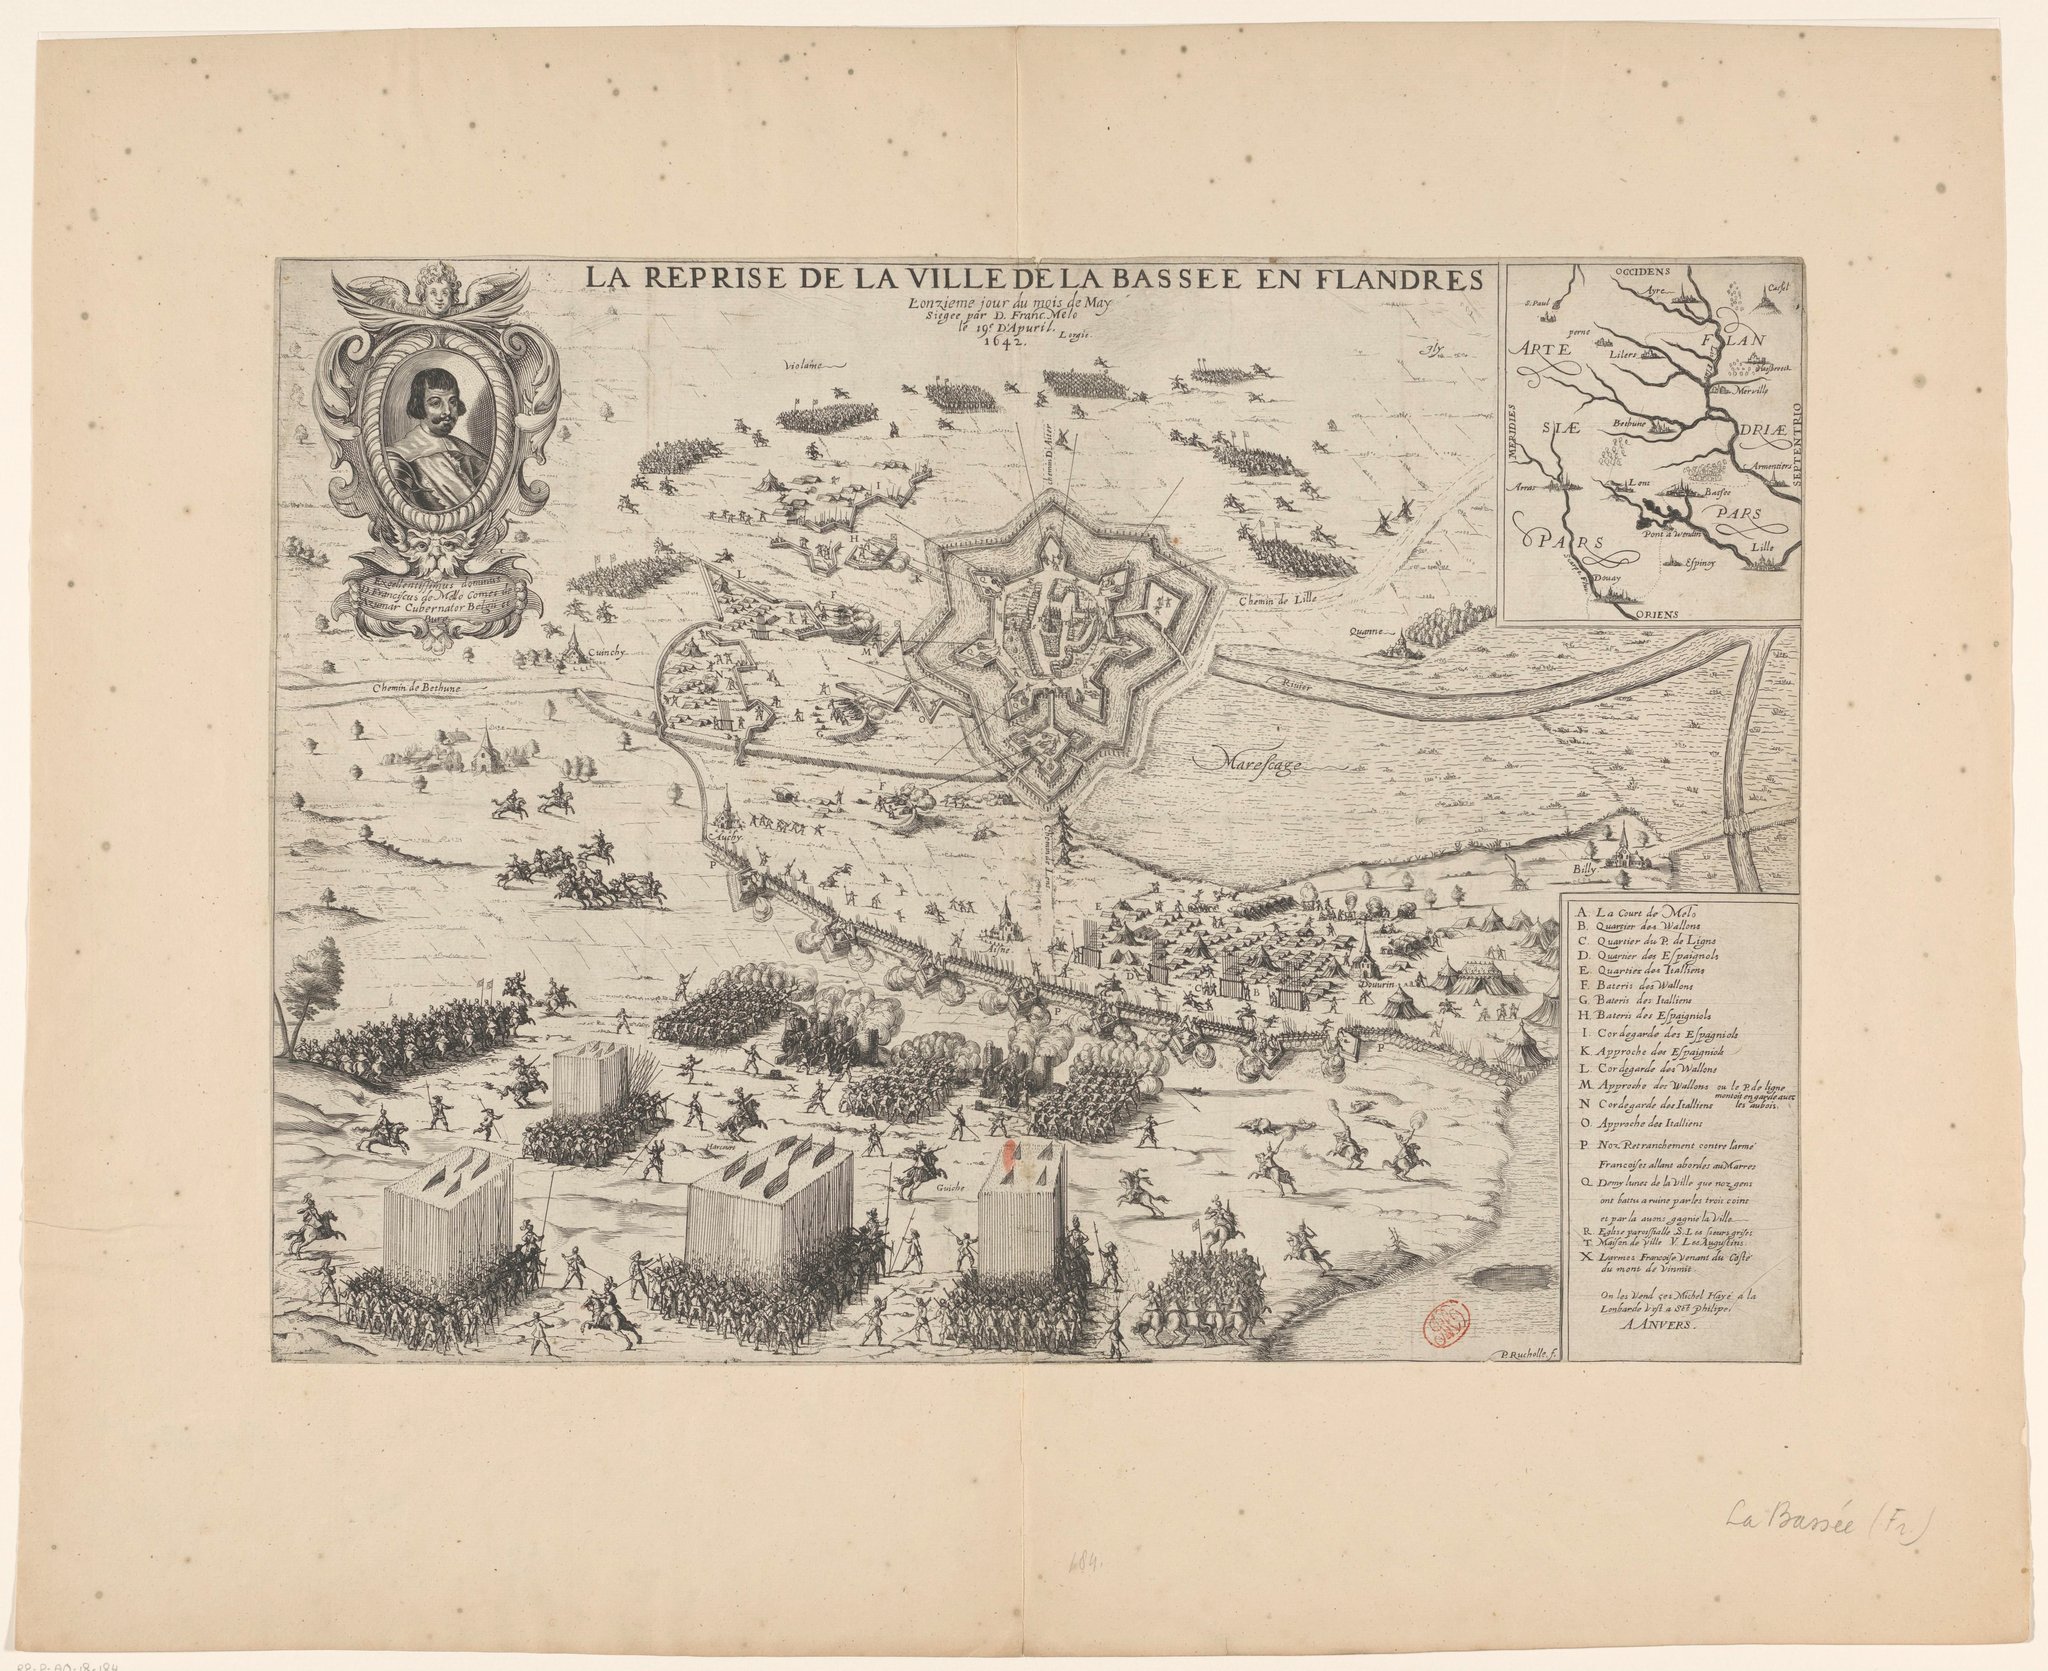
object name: print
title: Herovering van La Bassée door Francisco de Melo, 1642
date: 1642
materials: paper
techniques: engraving, etching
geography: antwerp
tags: maps of separate countries or regions, siege, position war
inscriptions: collector's mark: Lugt 195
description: Kaart met de herovering van de vestingstad La Bassée door het Spaanse leger onder landvoogd Francisco de Melo op 11 mei na een belegering begonnen op 19 april 1642. Centraal de versterkte stad, op de voorgrond de belegerende troepen. Linksboven een portret van De Melo, rechtsboven een inzet met een kaartje van het groter gebied. Rechtsonder de legenda A-X.